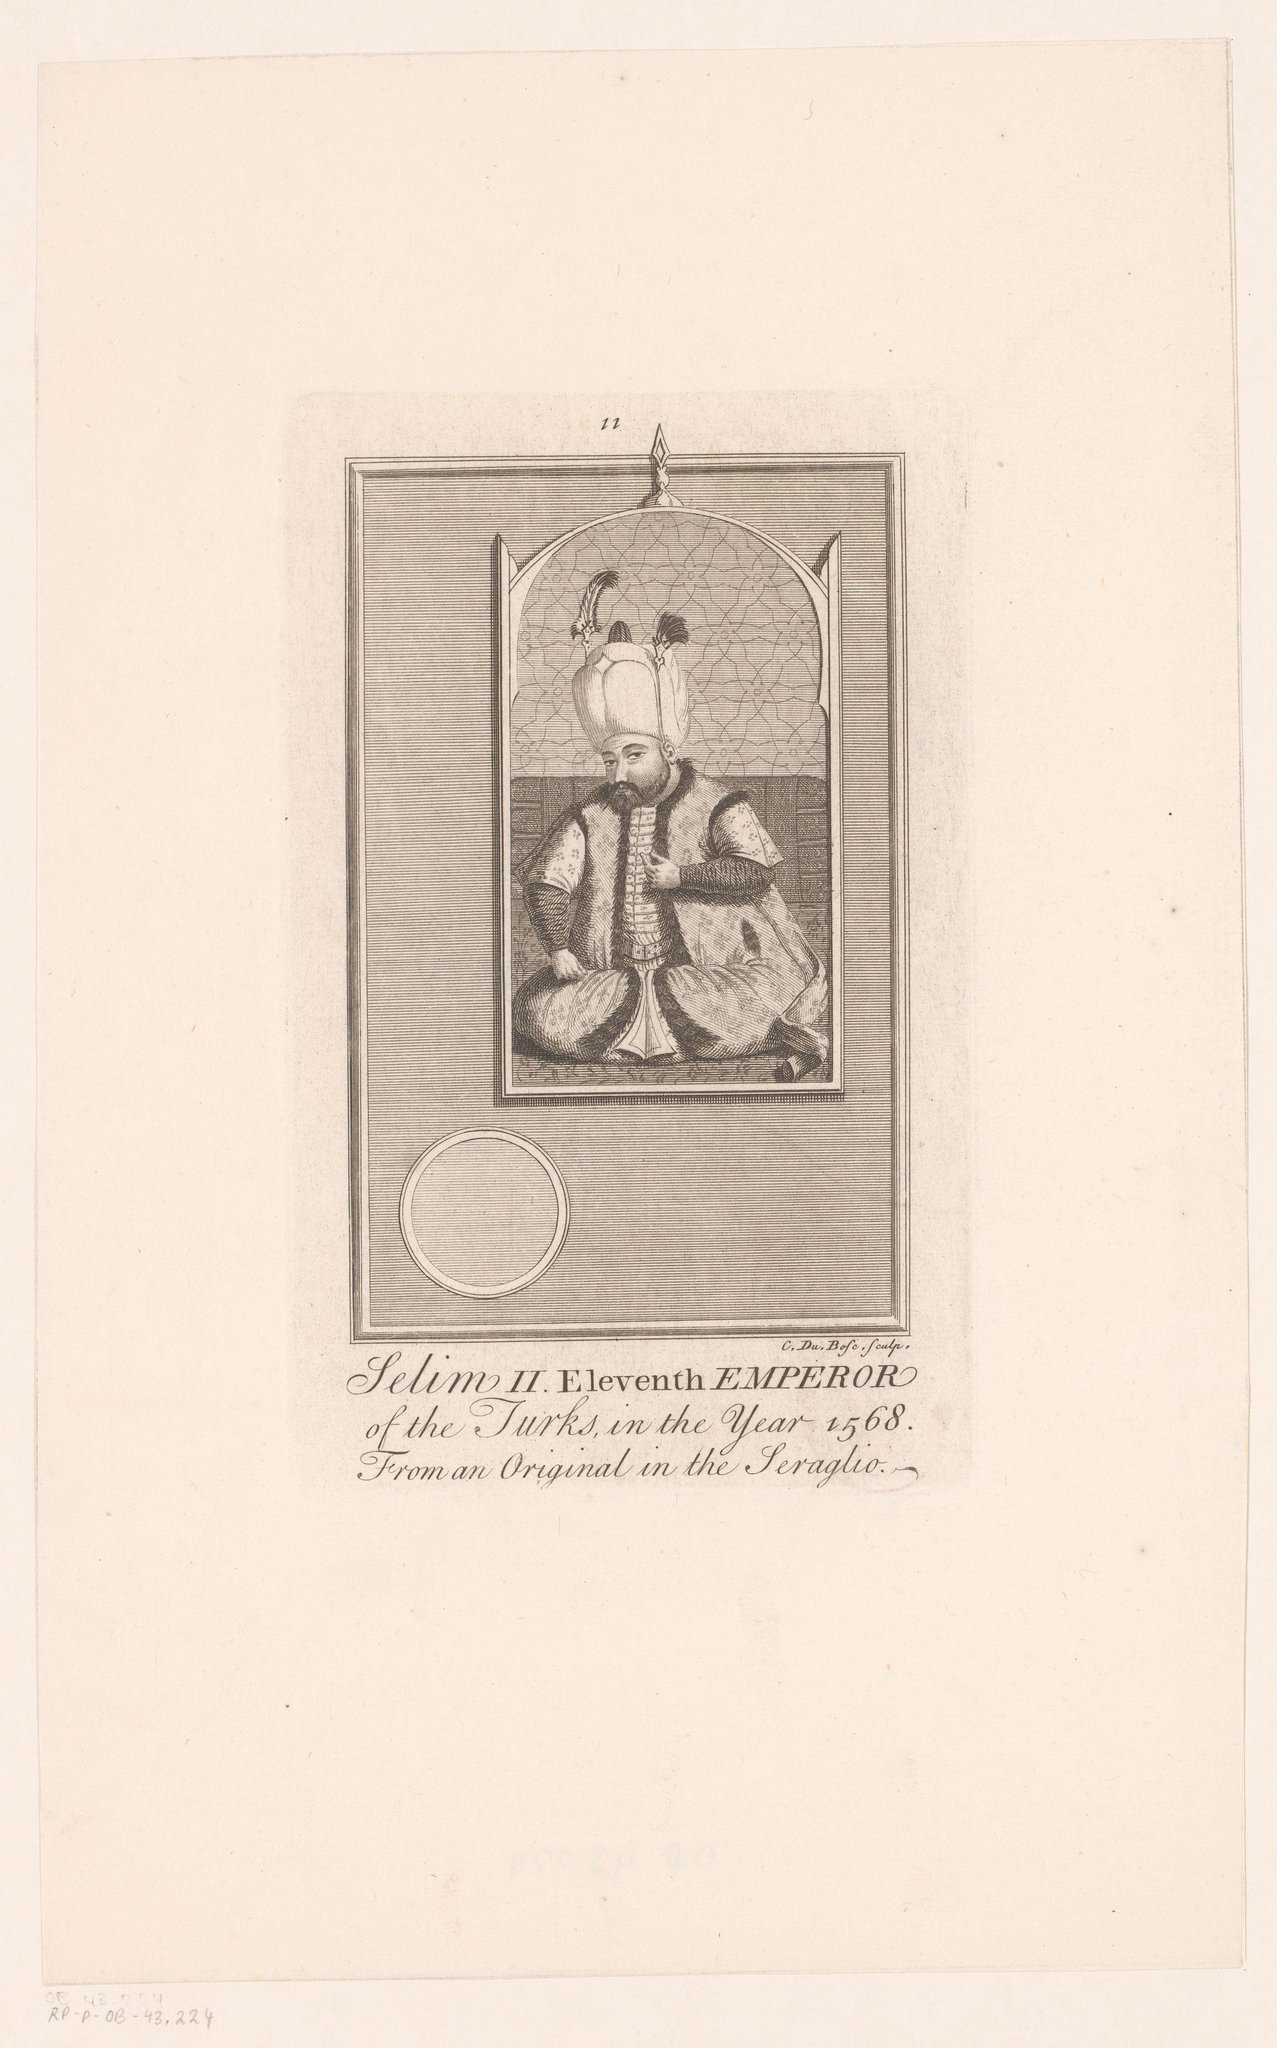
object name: print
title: Portret van Selim II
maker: claude dubosc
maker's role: print maker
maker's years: 1682-1745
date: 1692-1745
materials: paper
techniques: engraving, etching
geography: france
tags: historical persons, ruler, sovereign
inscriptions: collector's mark: Lugt 240